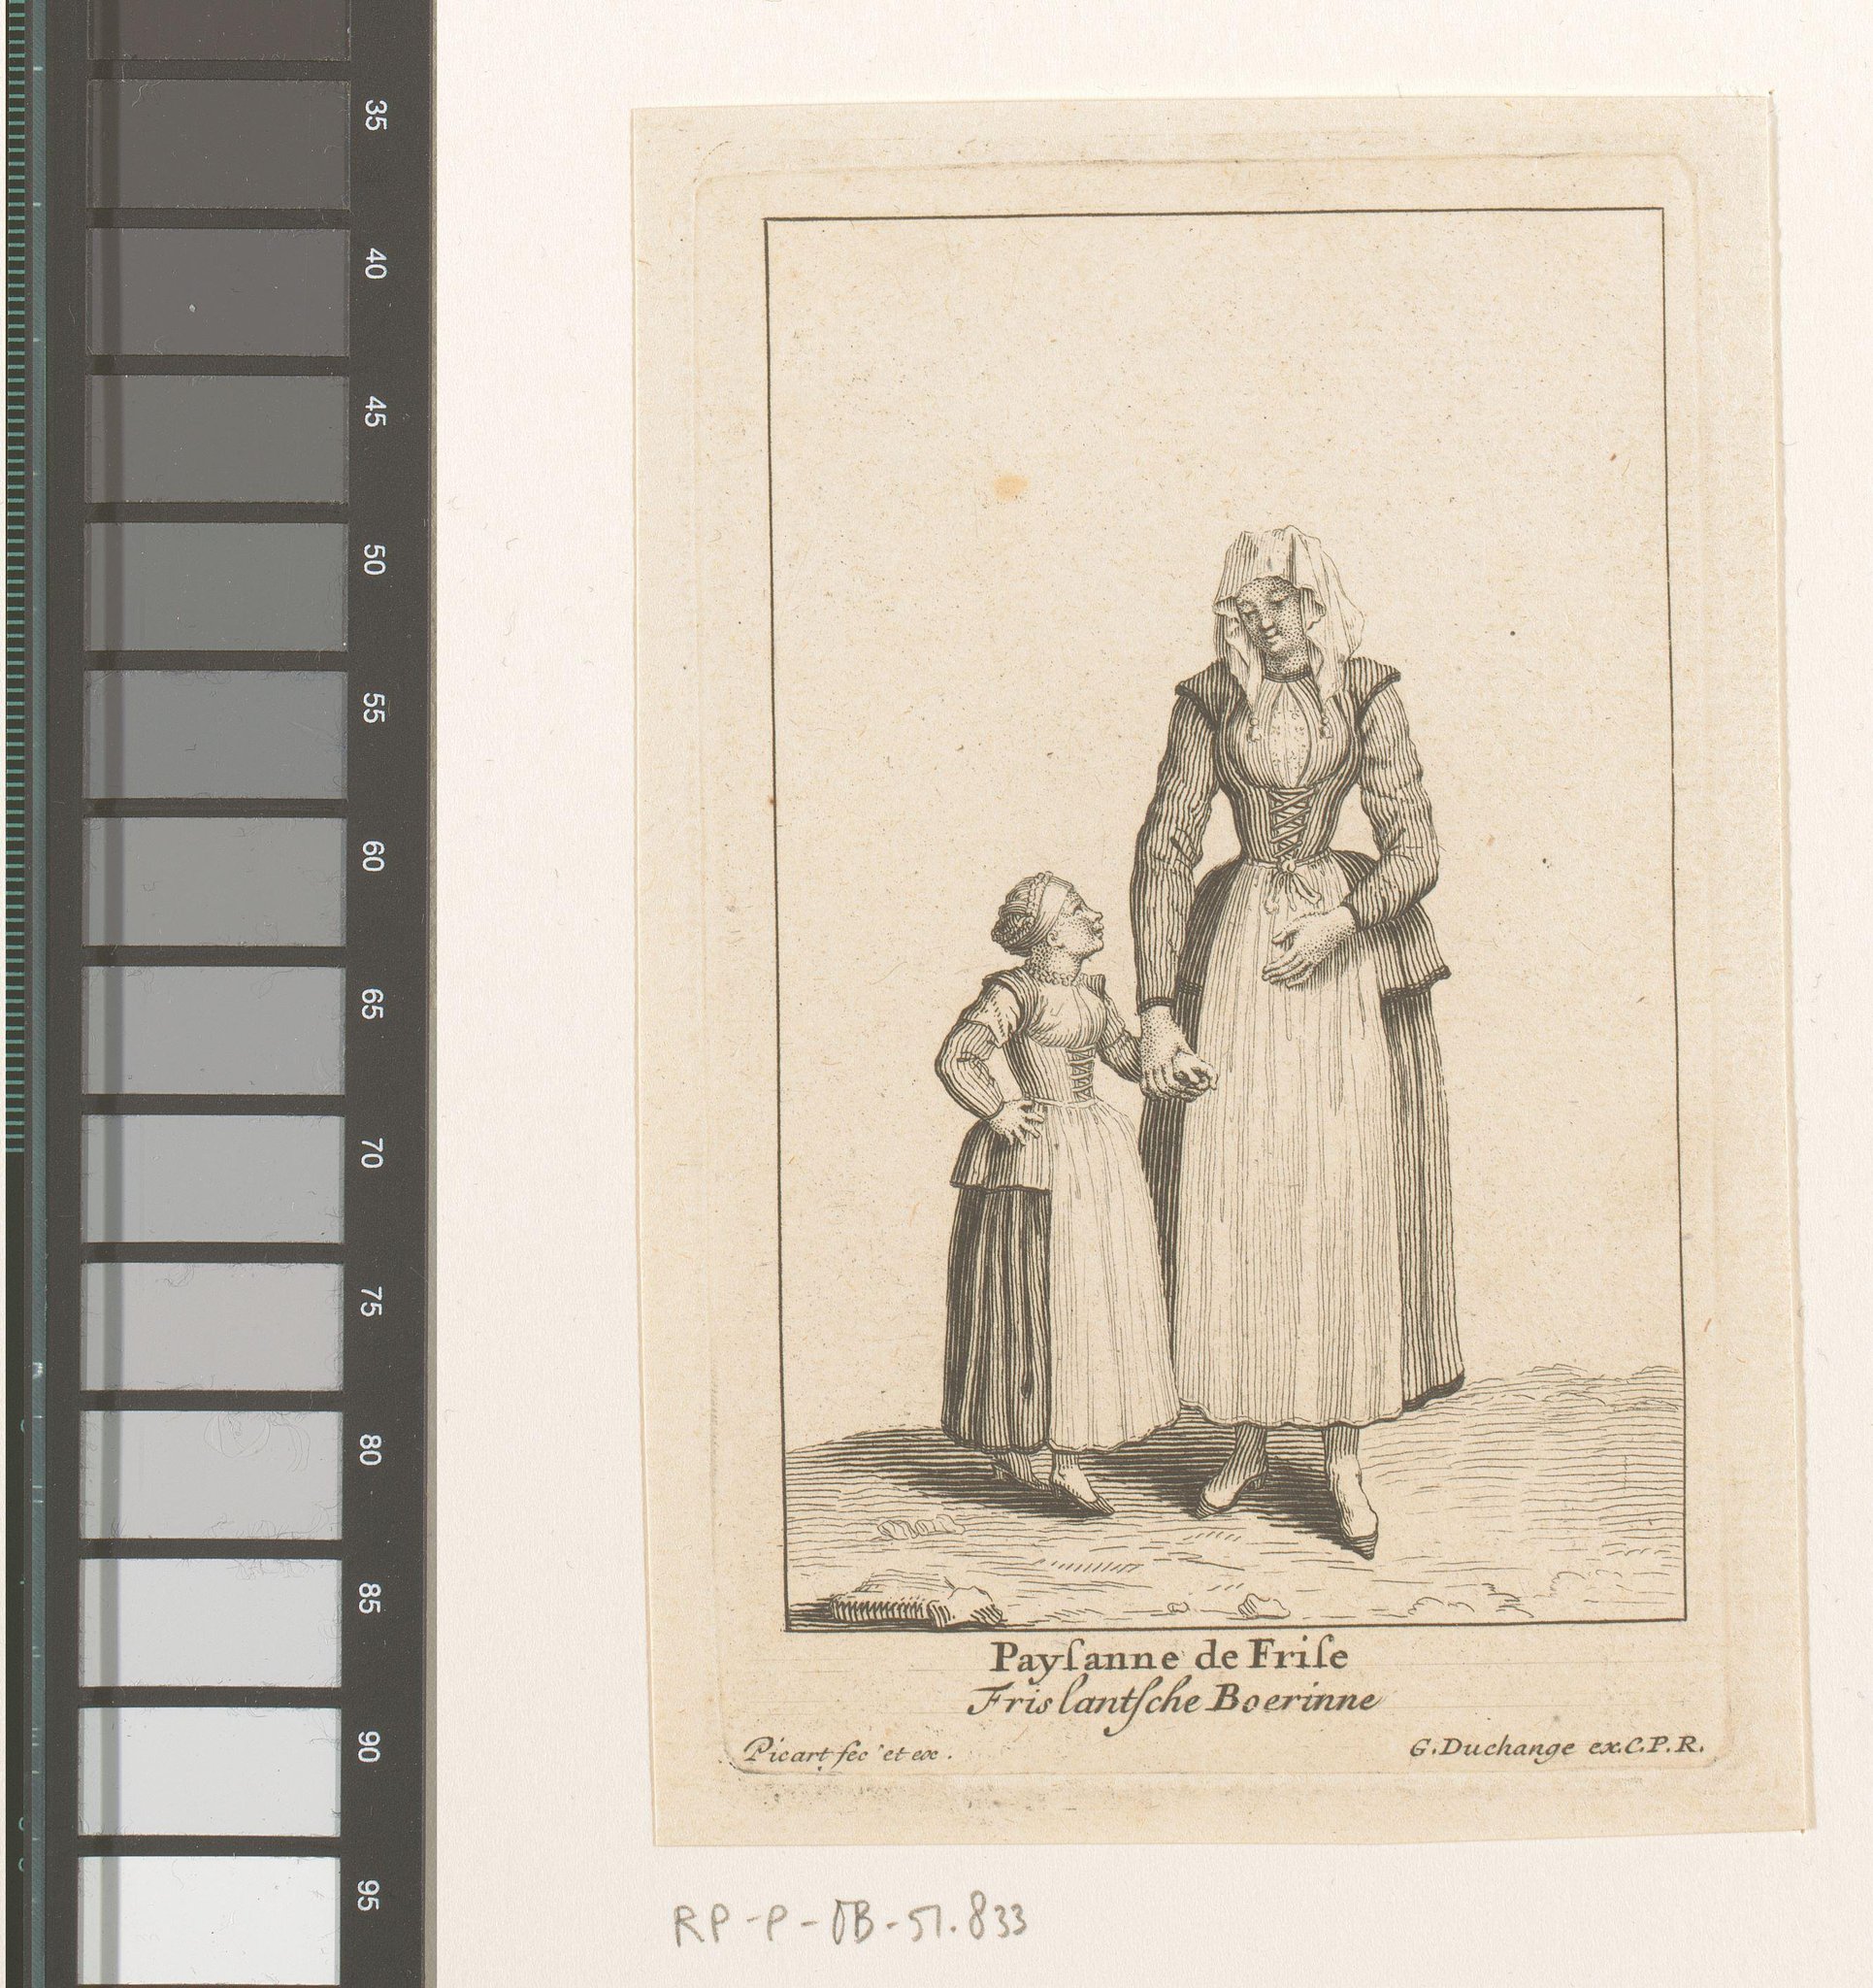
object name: costume print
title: Friese boerin met haar dochter aan de hand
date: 1728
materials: paper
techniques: engraving, etching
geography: amsterdam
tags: folk costume, regional costume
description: Prent waarschijnlijk ook opgenomen in: Diverses modes dessinées d'après Nature. Amsterdam: Bernard Picart, 1728.